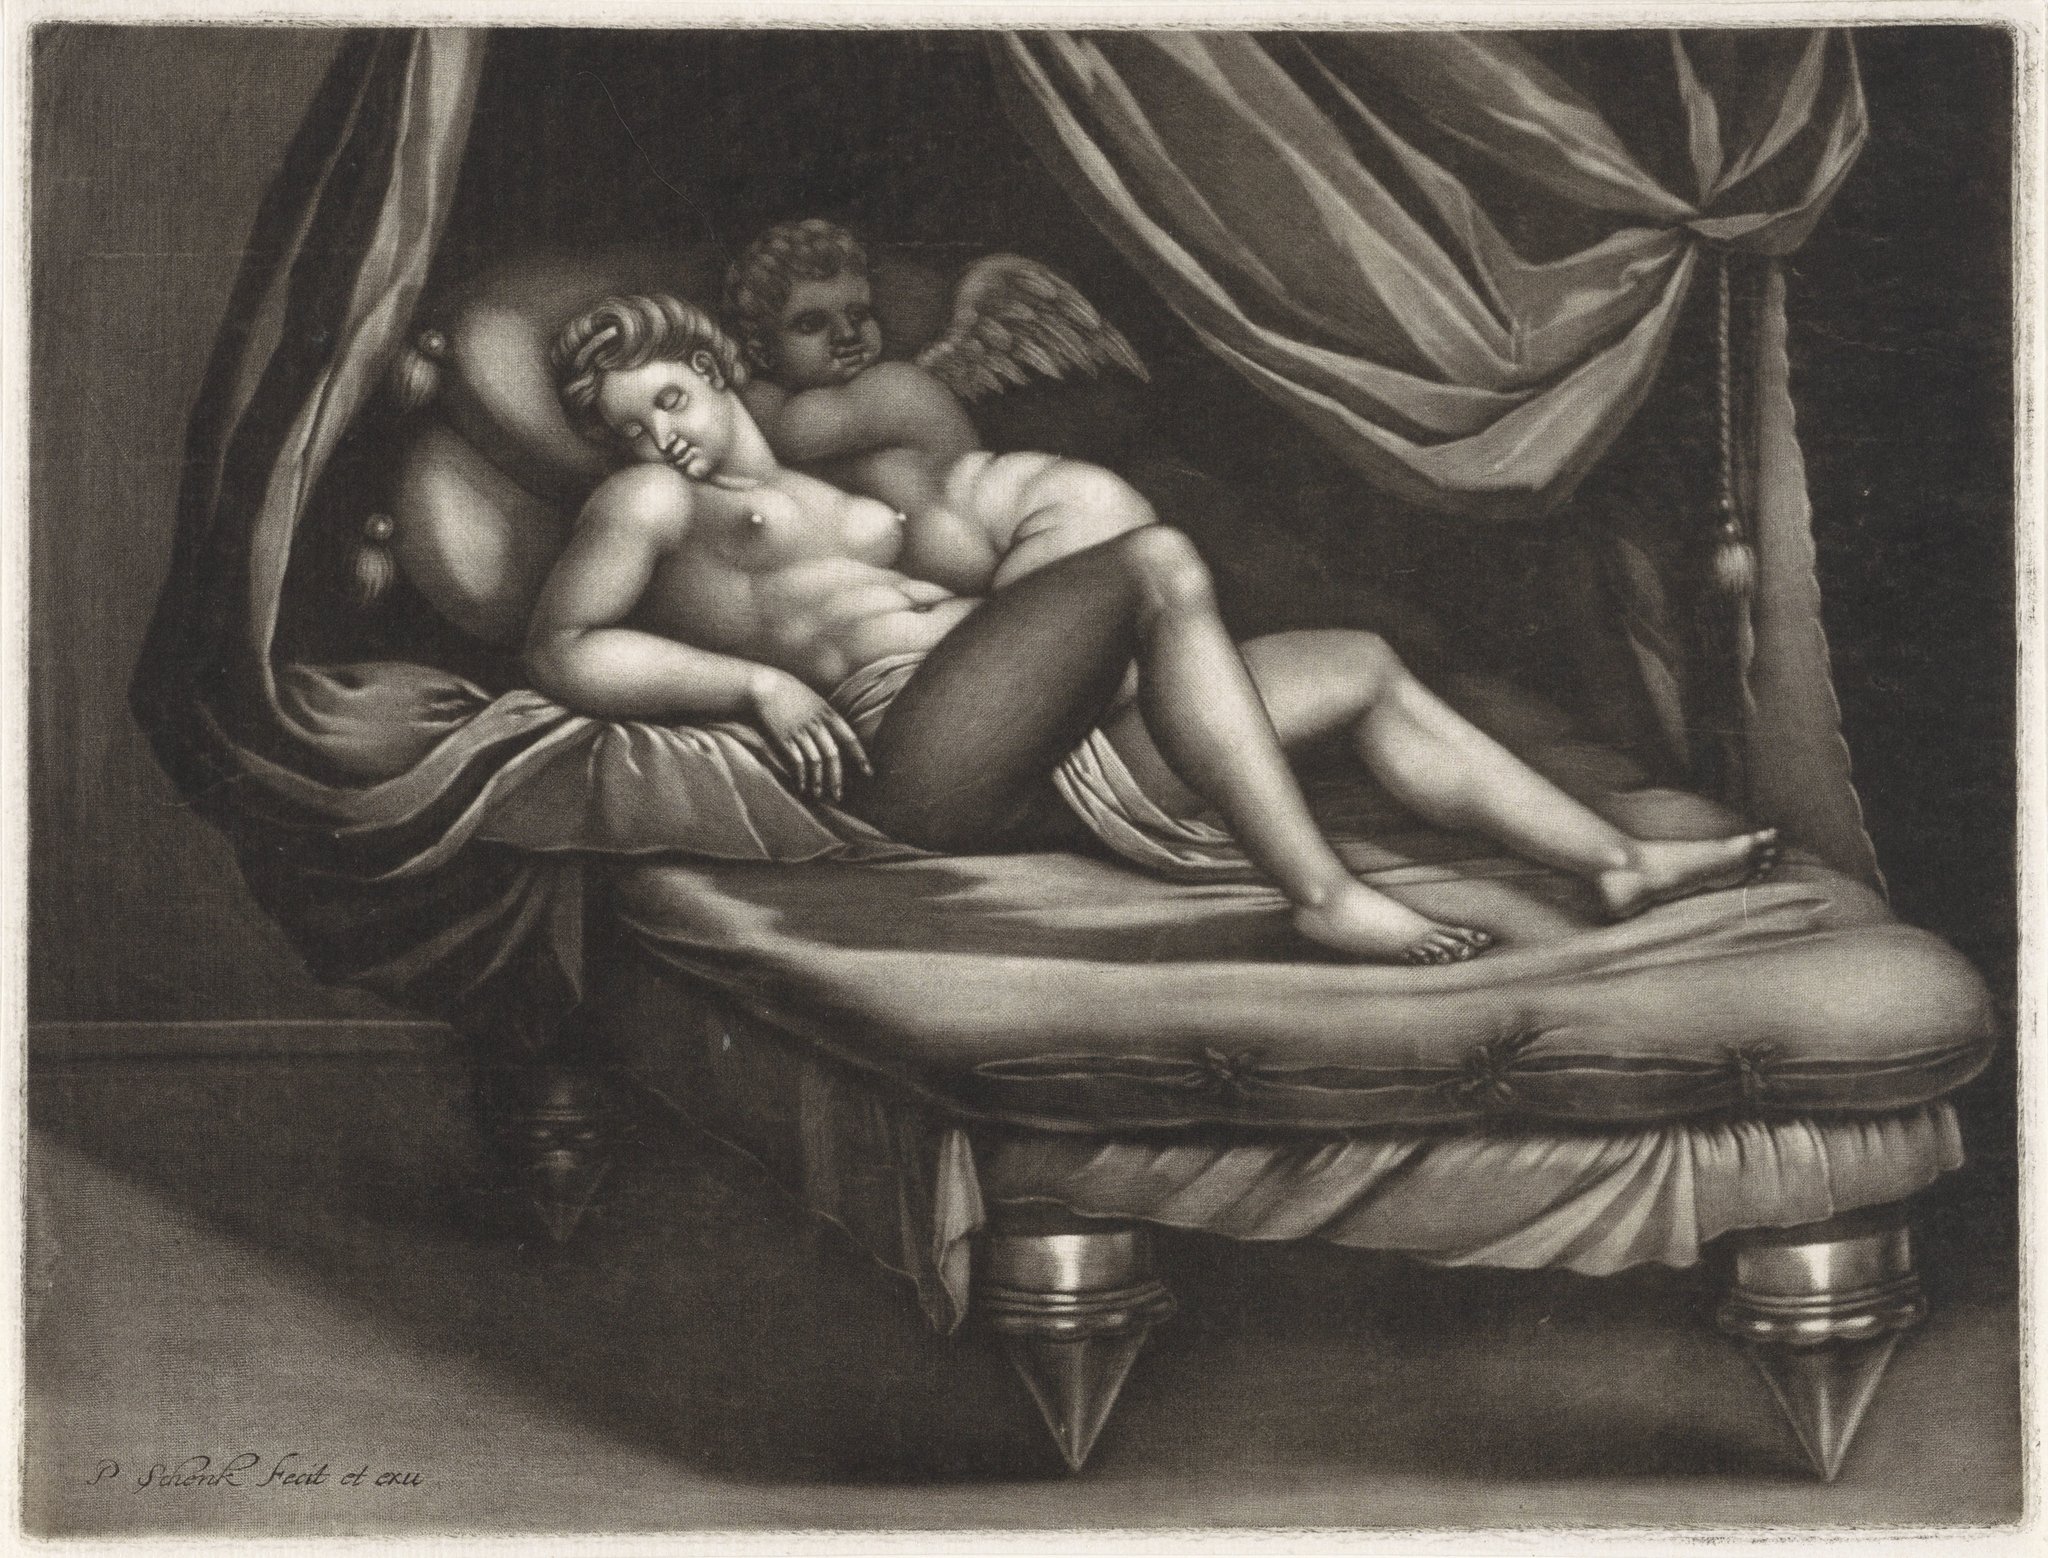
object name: print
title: Cupido en Psyche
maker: pieter schenk (i)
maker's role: print maker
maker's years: 1660-1711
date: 1670-1713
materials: paper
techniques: mezzotint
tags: bed, venus and cupid (cupid not being mere attribute)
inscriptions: collector's mark: Lugt 2228